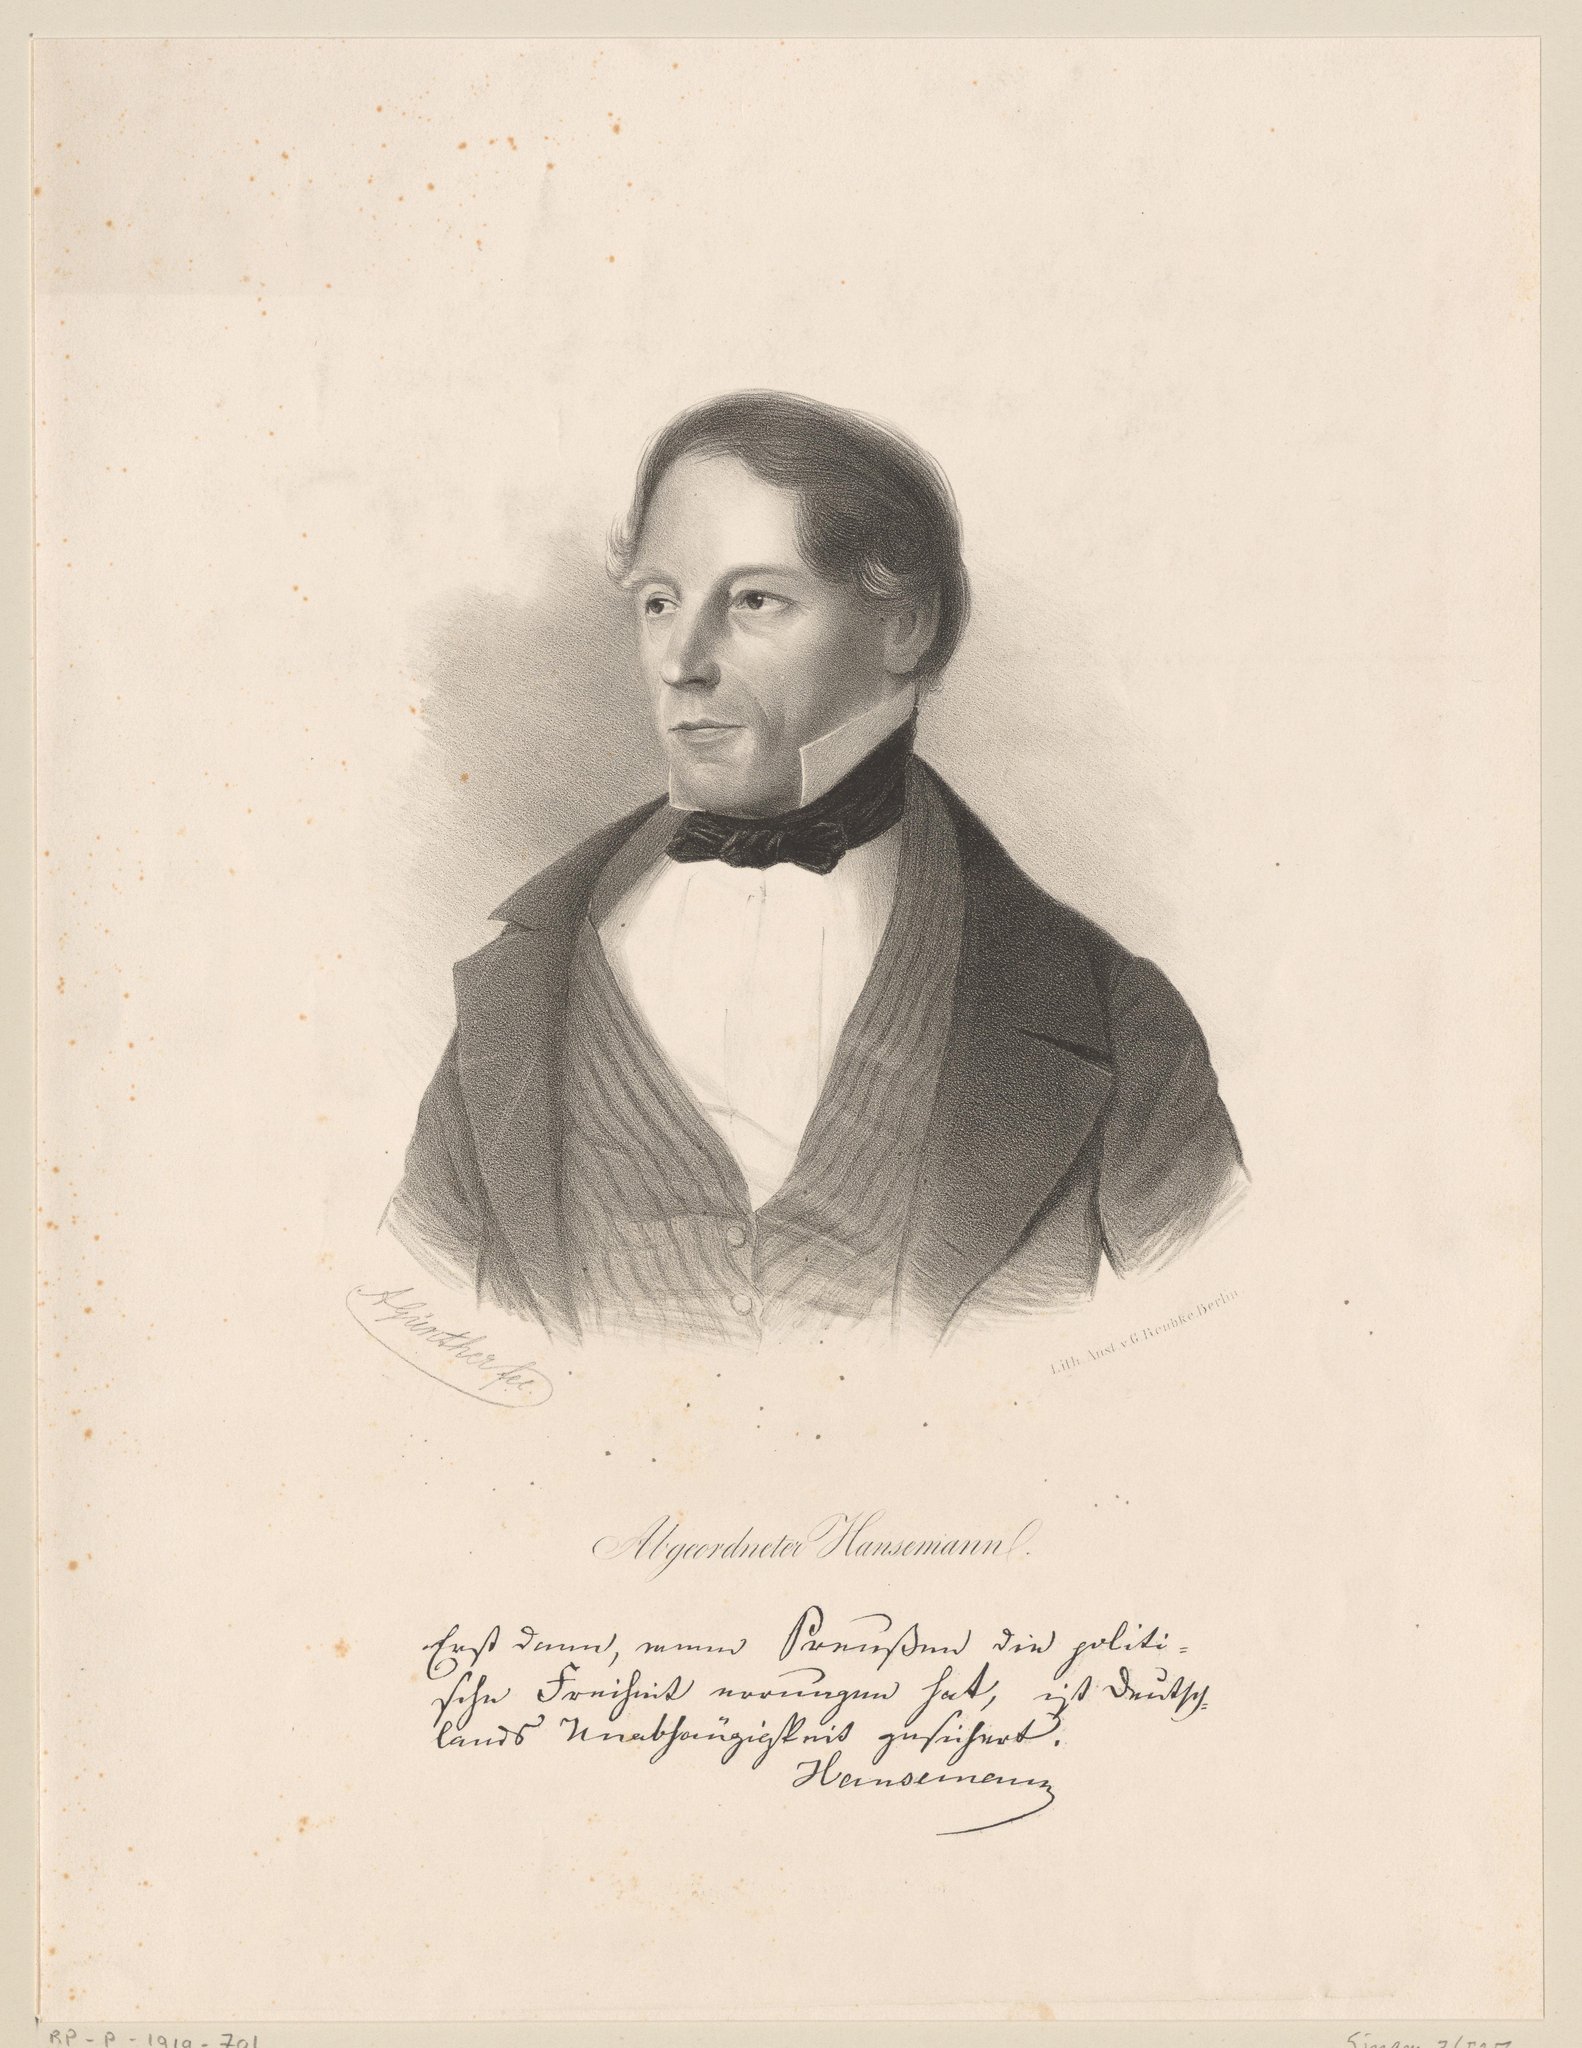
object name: print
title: Portret van David Hansemann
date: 1832-1860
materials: paper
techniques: lithograph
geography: berlin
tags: historical persons, politician, e.g. party leader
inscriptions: collector's mark: Lugt 2228